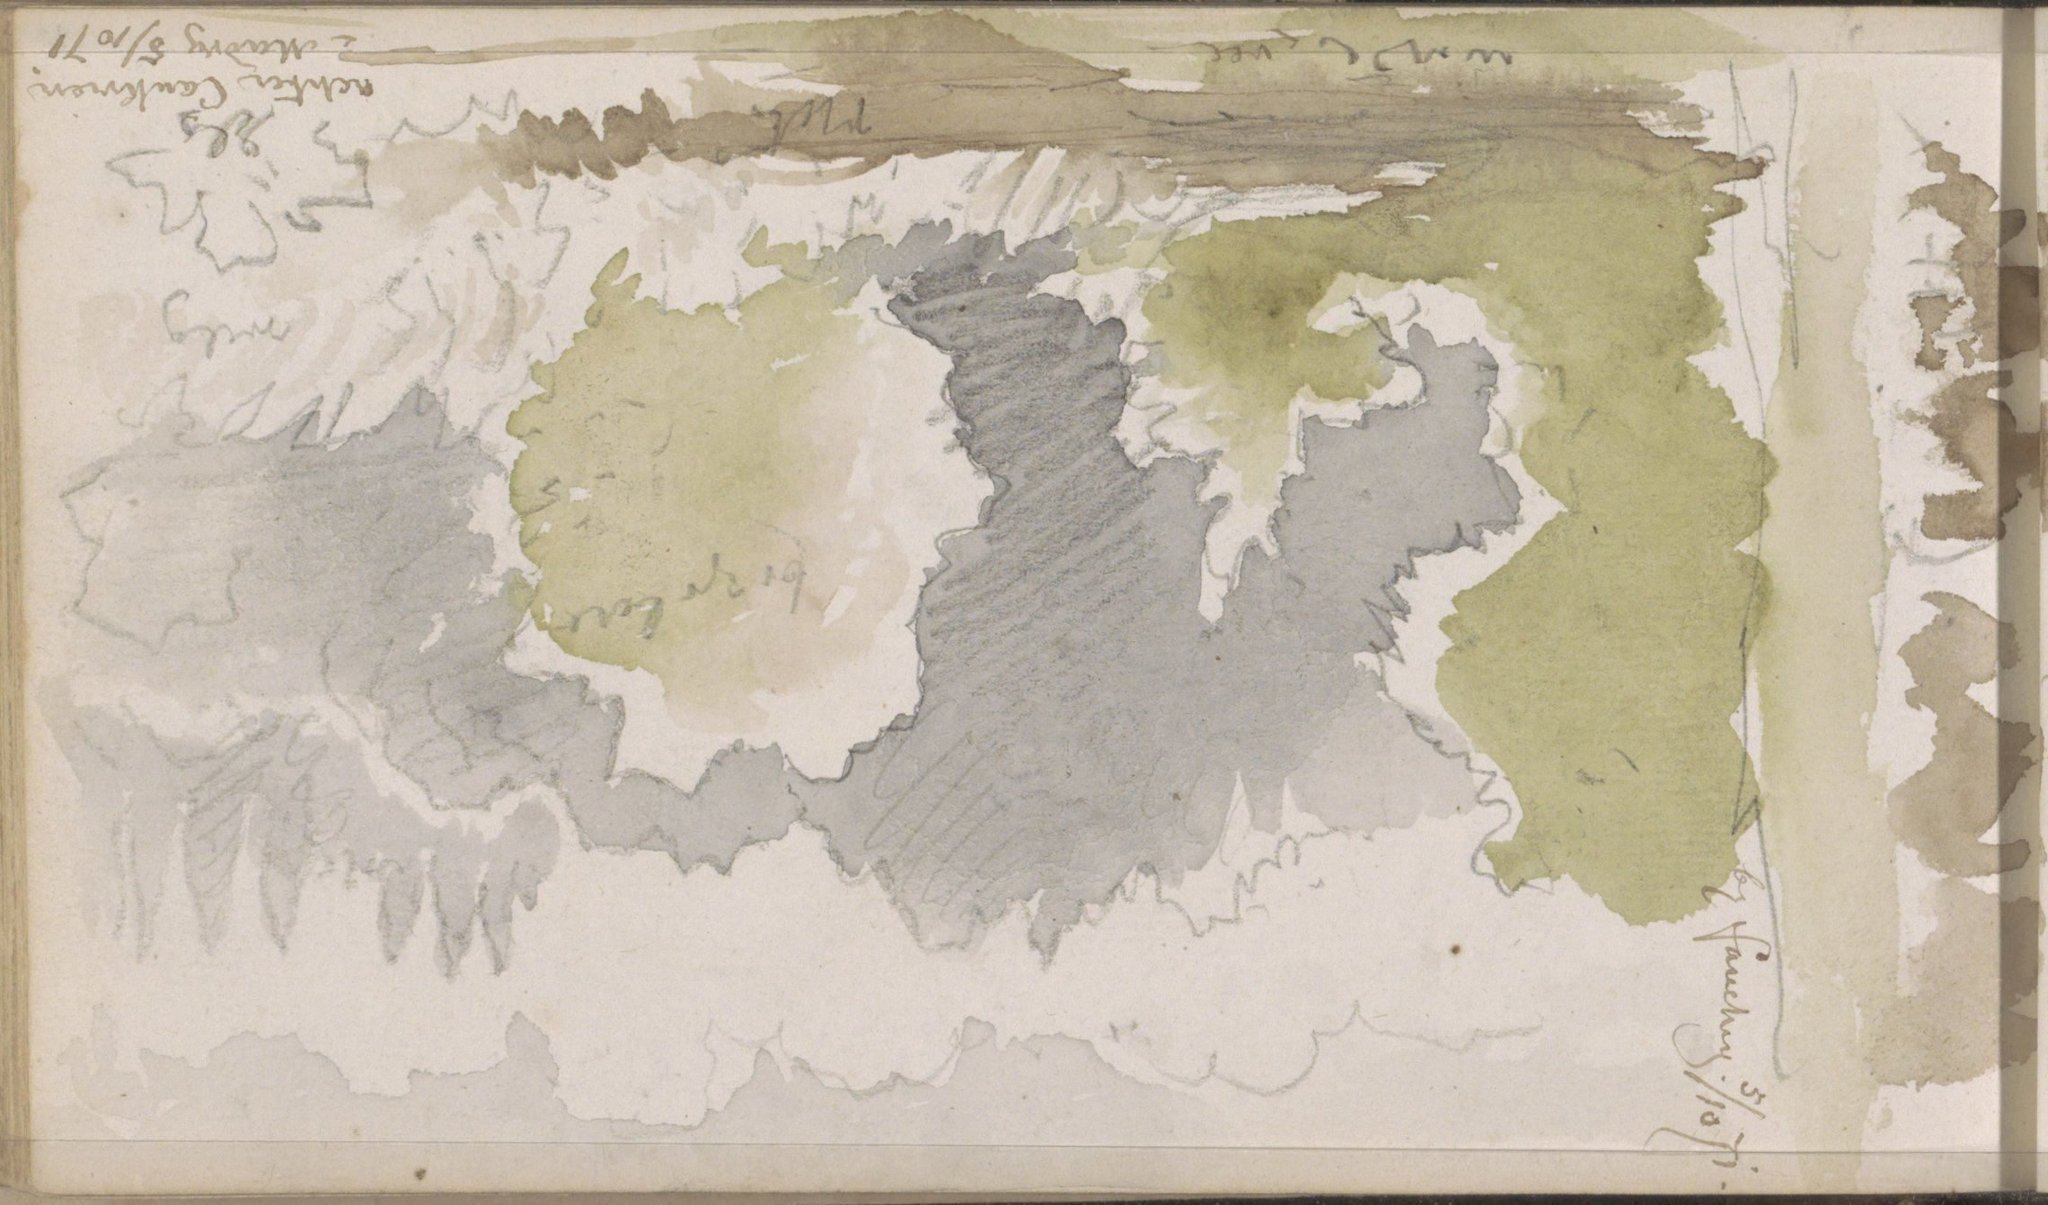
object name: sketchbook leaf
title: Landschap, vermoedelijk in de omgeving van Rotterdam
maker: johannes tavenraat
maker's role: draughtsman, painter, print maker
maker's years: 1809-1881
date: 1810-1871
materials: ink, paper, pencil, watercolor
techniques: brush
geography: rotterdam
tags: landscapes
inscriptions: date and inscription: ‘bij [...]auch[...] 5/10 71./ achter Ca[...]ien/ & Madry 5/10 71’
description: Blad 82 verso uit een schetsboek met 98 bladen.